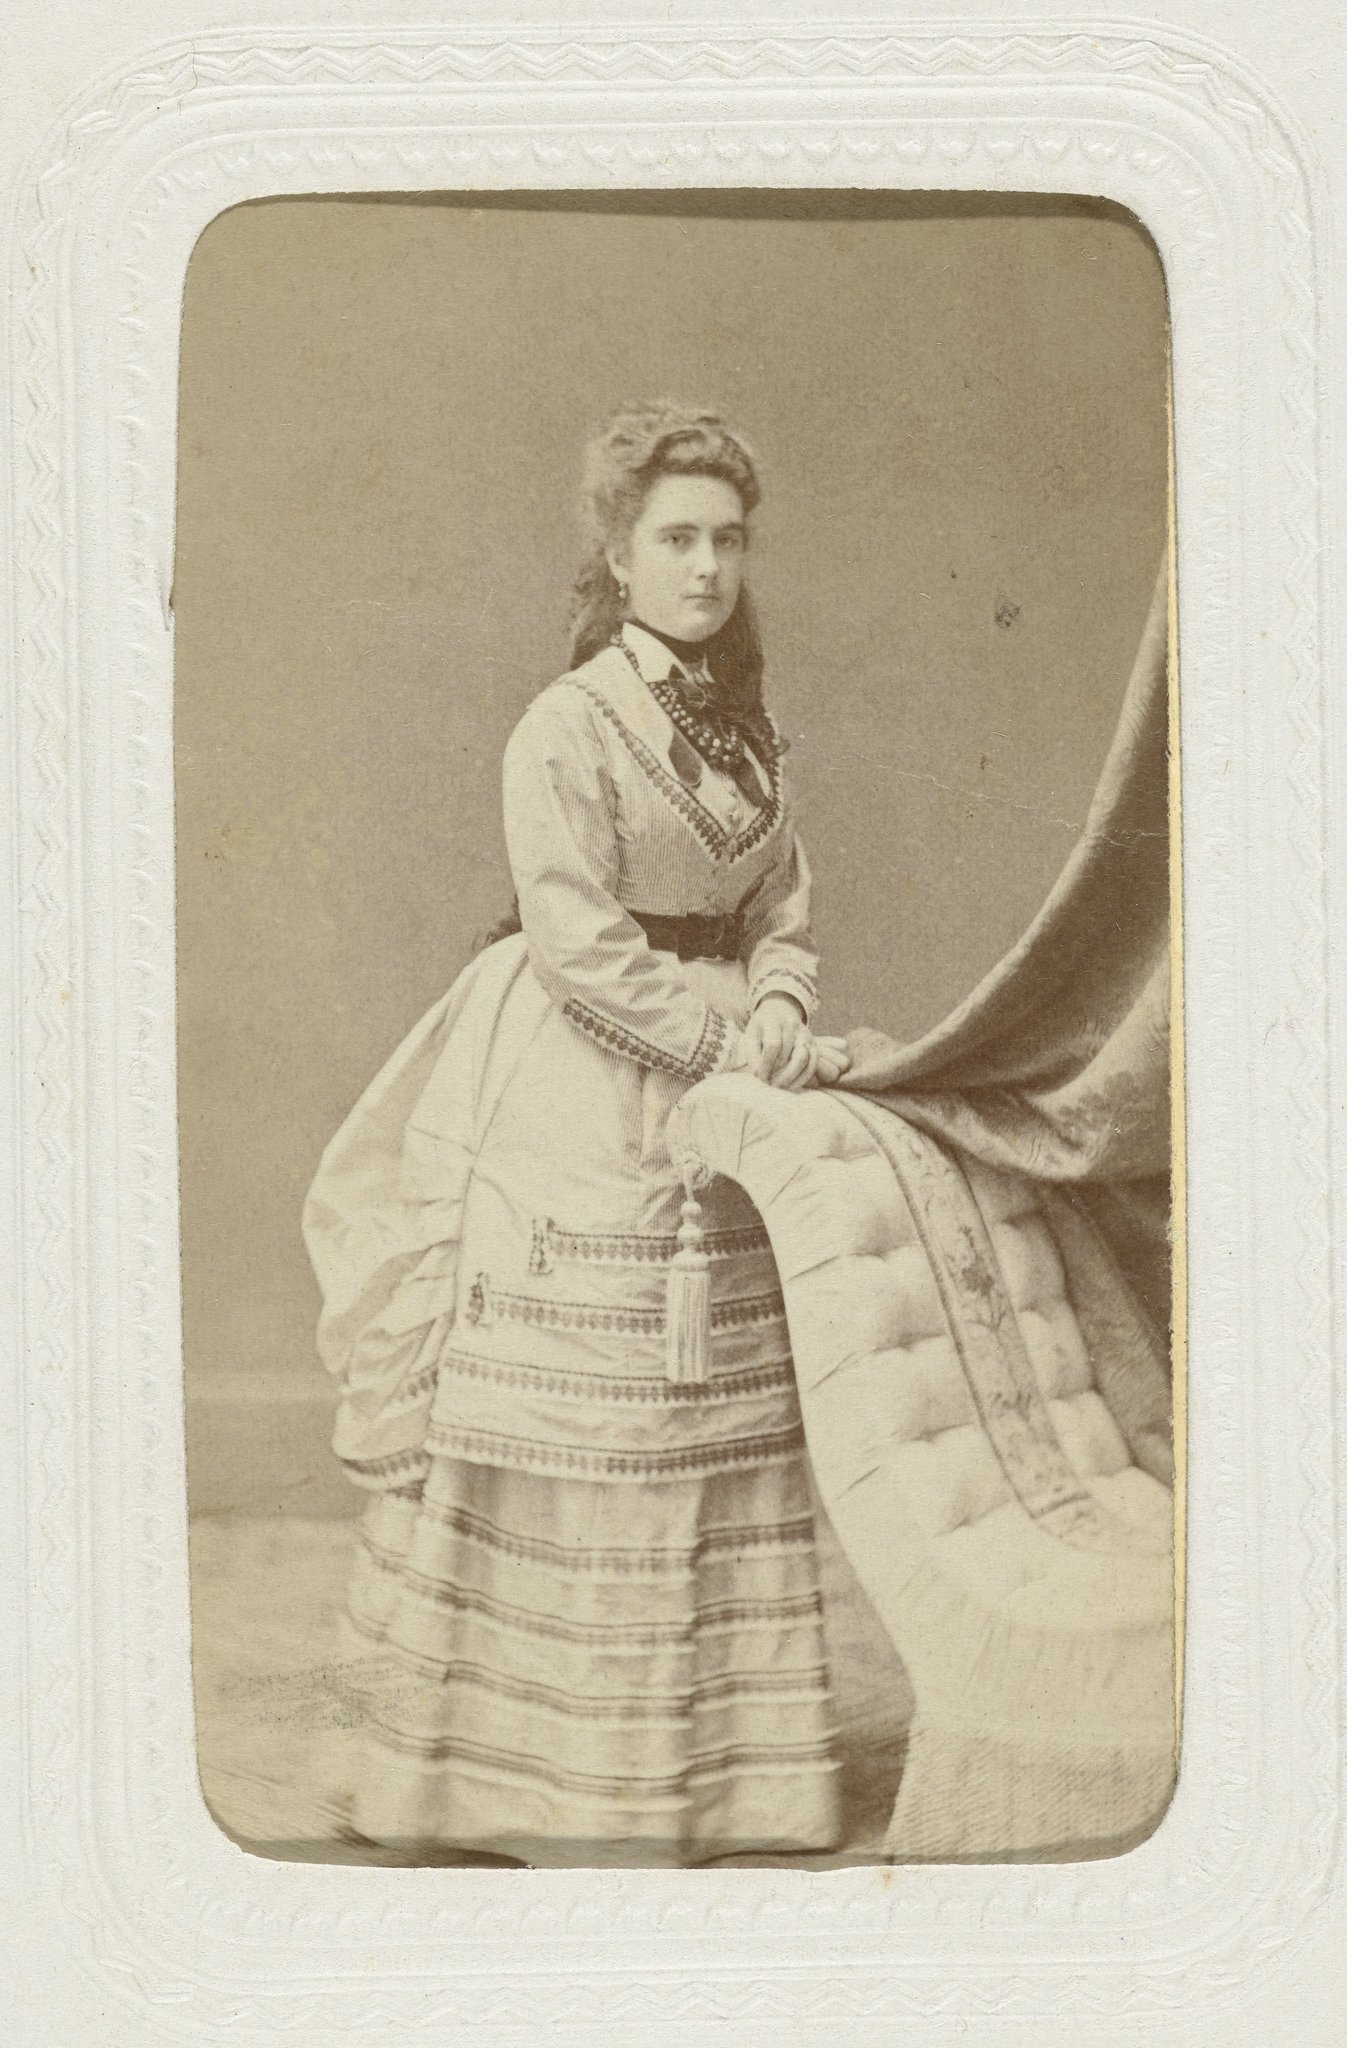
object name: carte de visite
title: Studioportret van een vrouw bij een stoel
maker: august kampf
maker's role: fotograaf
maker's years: 1836-1914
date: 1863-1866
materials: cardboard, paper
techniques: albumen print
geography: amsterdam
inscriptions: name: ‘August Kampf’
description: De achterkant van haar gestreepte jurk is voorzien van waaiervormige afzetting.